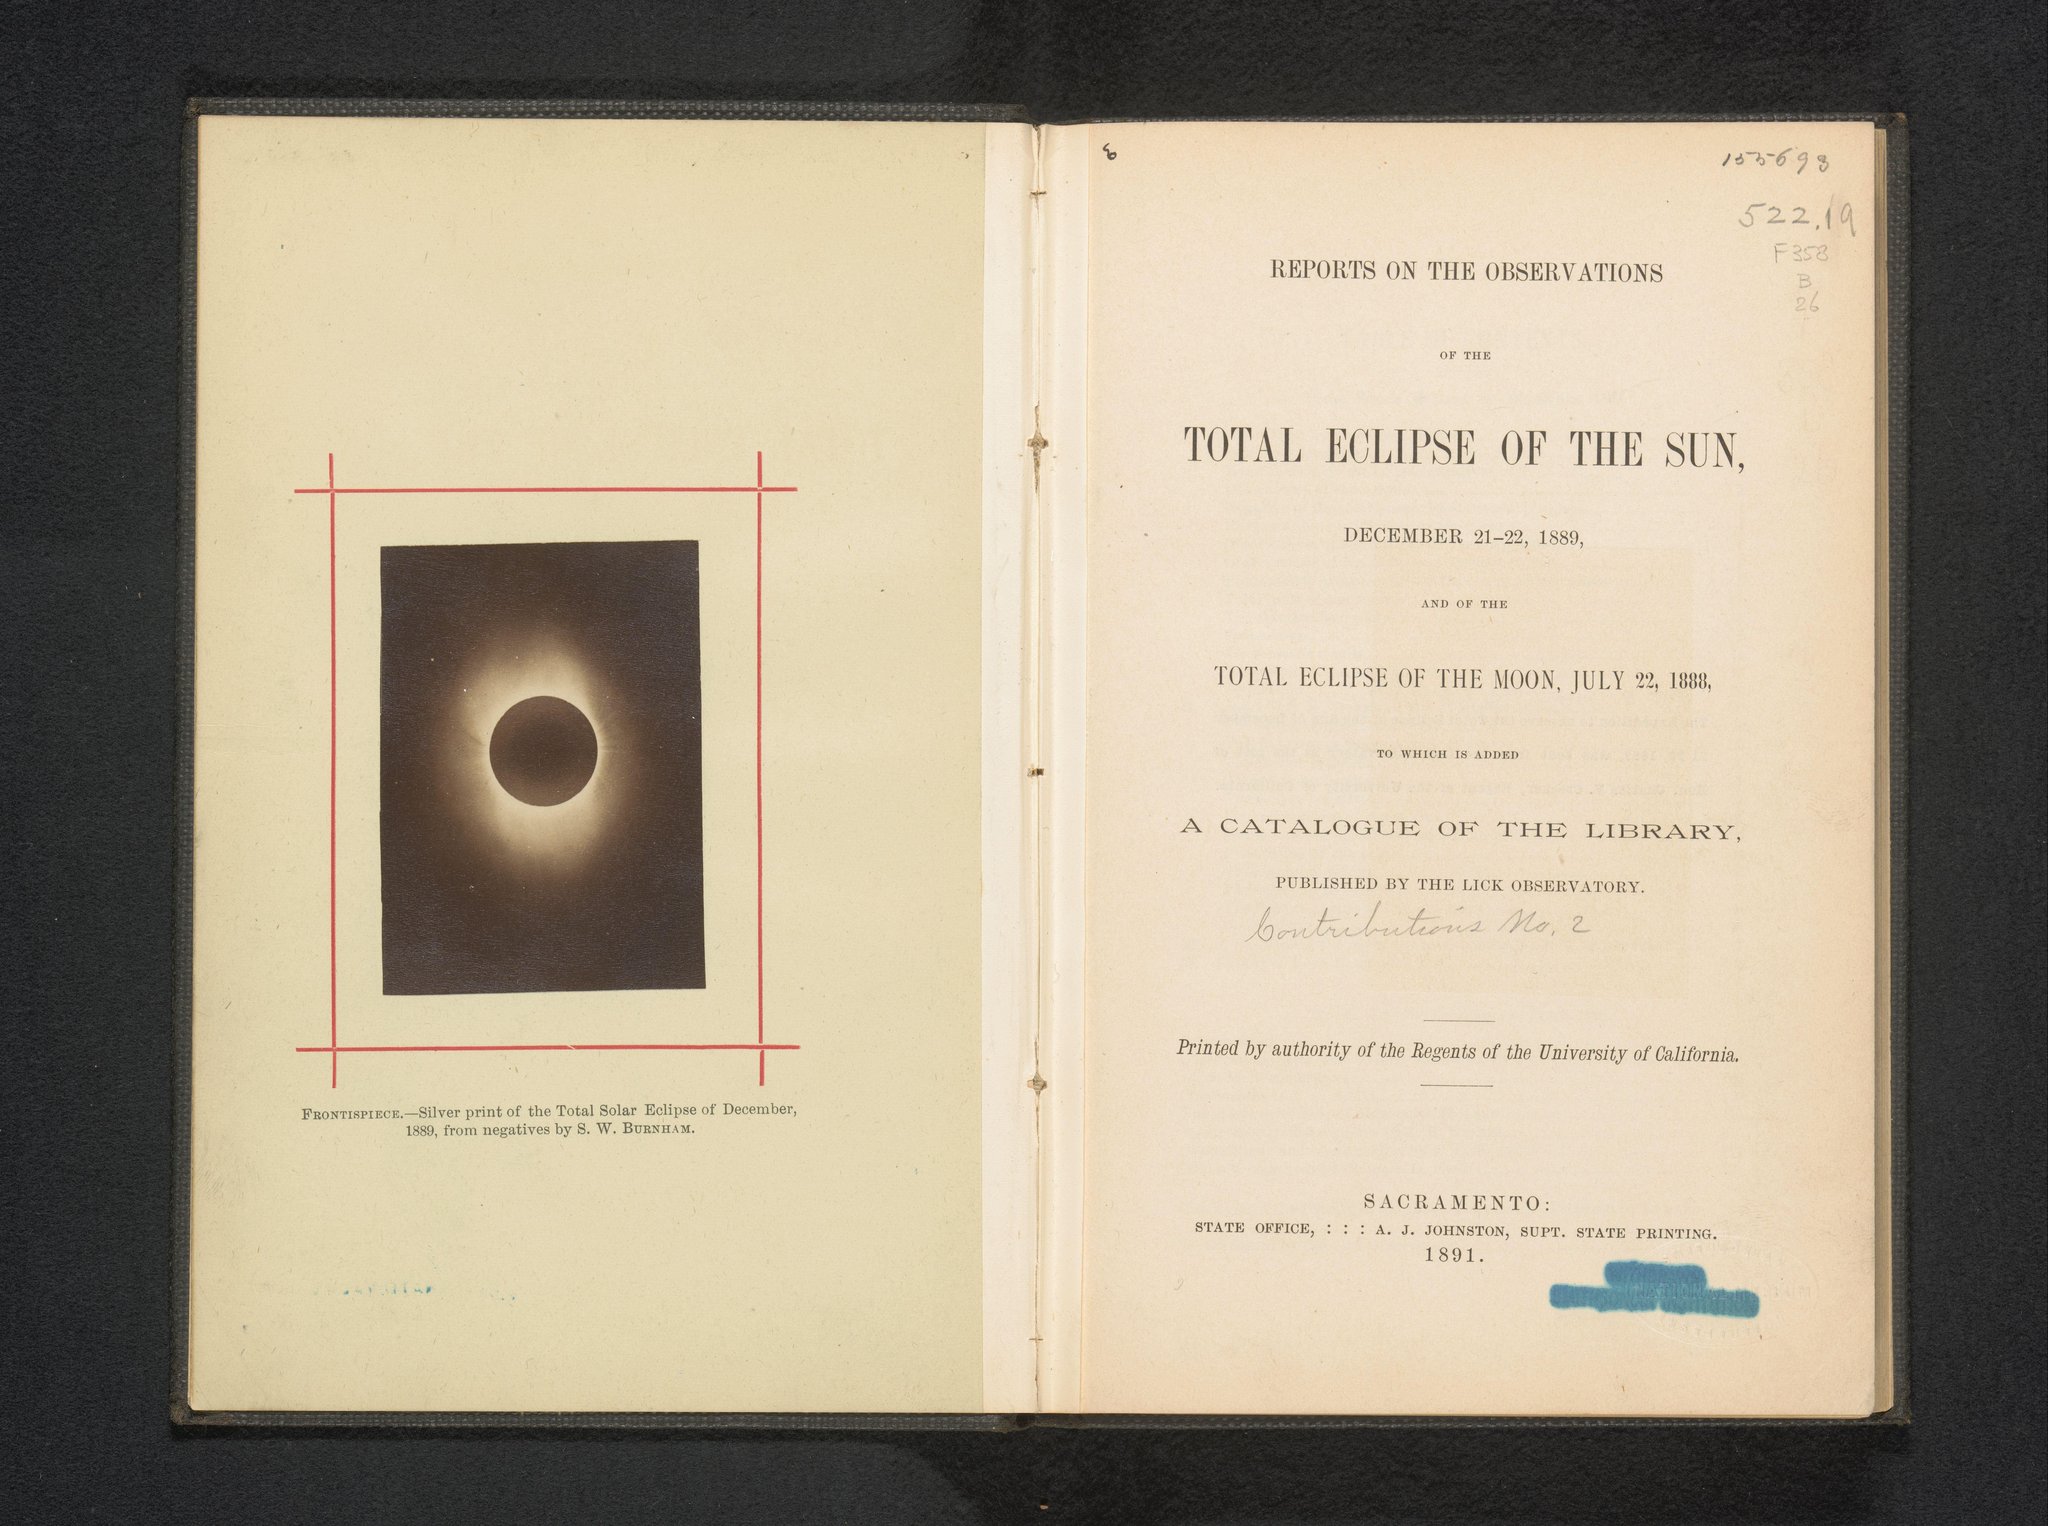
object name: book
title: Reports on the observations of the total eclipse of the sun, December 21-22, 1889 and of the total eclipse of the moon, July 22, 1888 : to which is added a catalogue of the library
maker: a.j. johnston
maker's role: publisher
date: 1891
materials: cardboard, leather, linen, paper, photographic support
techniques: albumen print, photograph, printing, engraving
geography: sacramento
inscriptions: date: ‘MAY/ 1990’, bookplate: ‘SMITHSONIAN/ NATIONAL MUSEUM/ INSTITUTION’